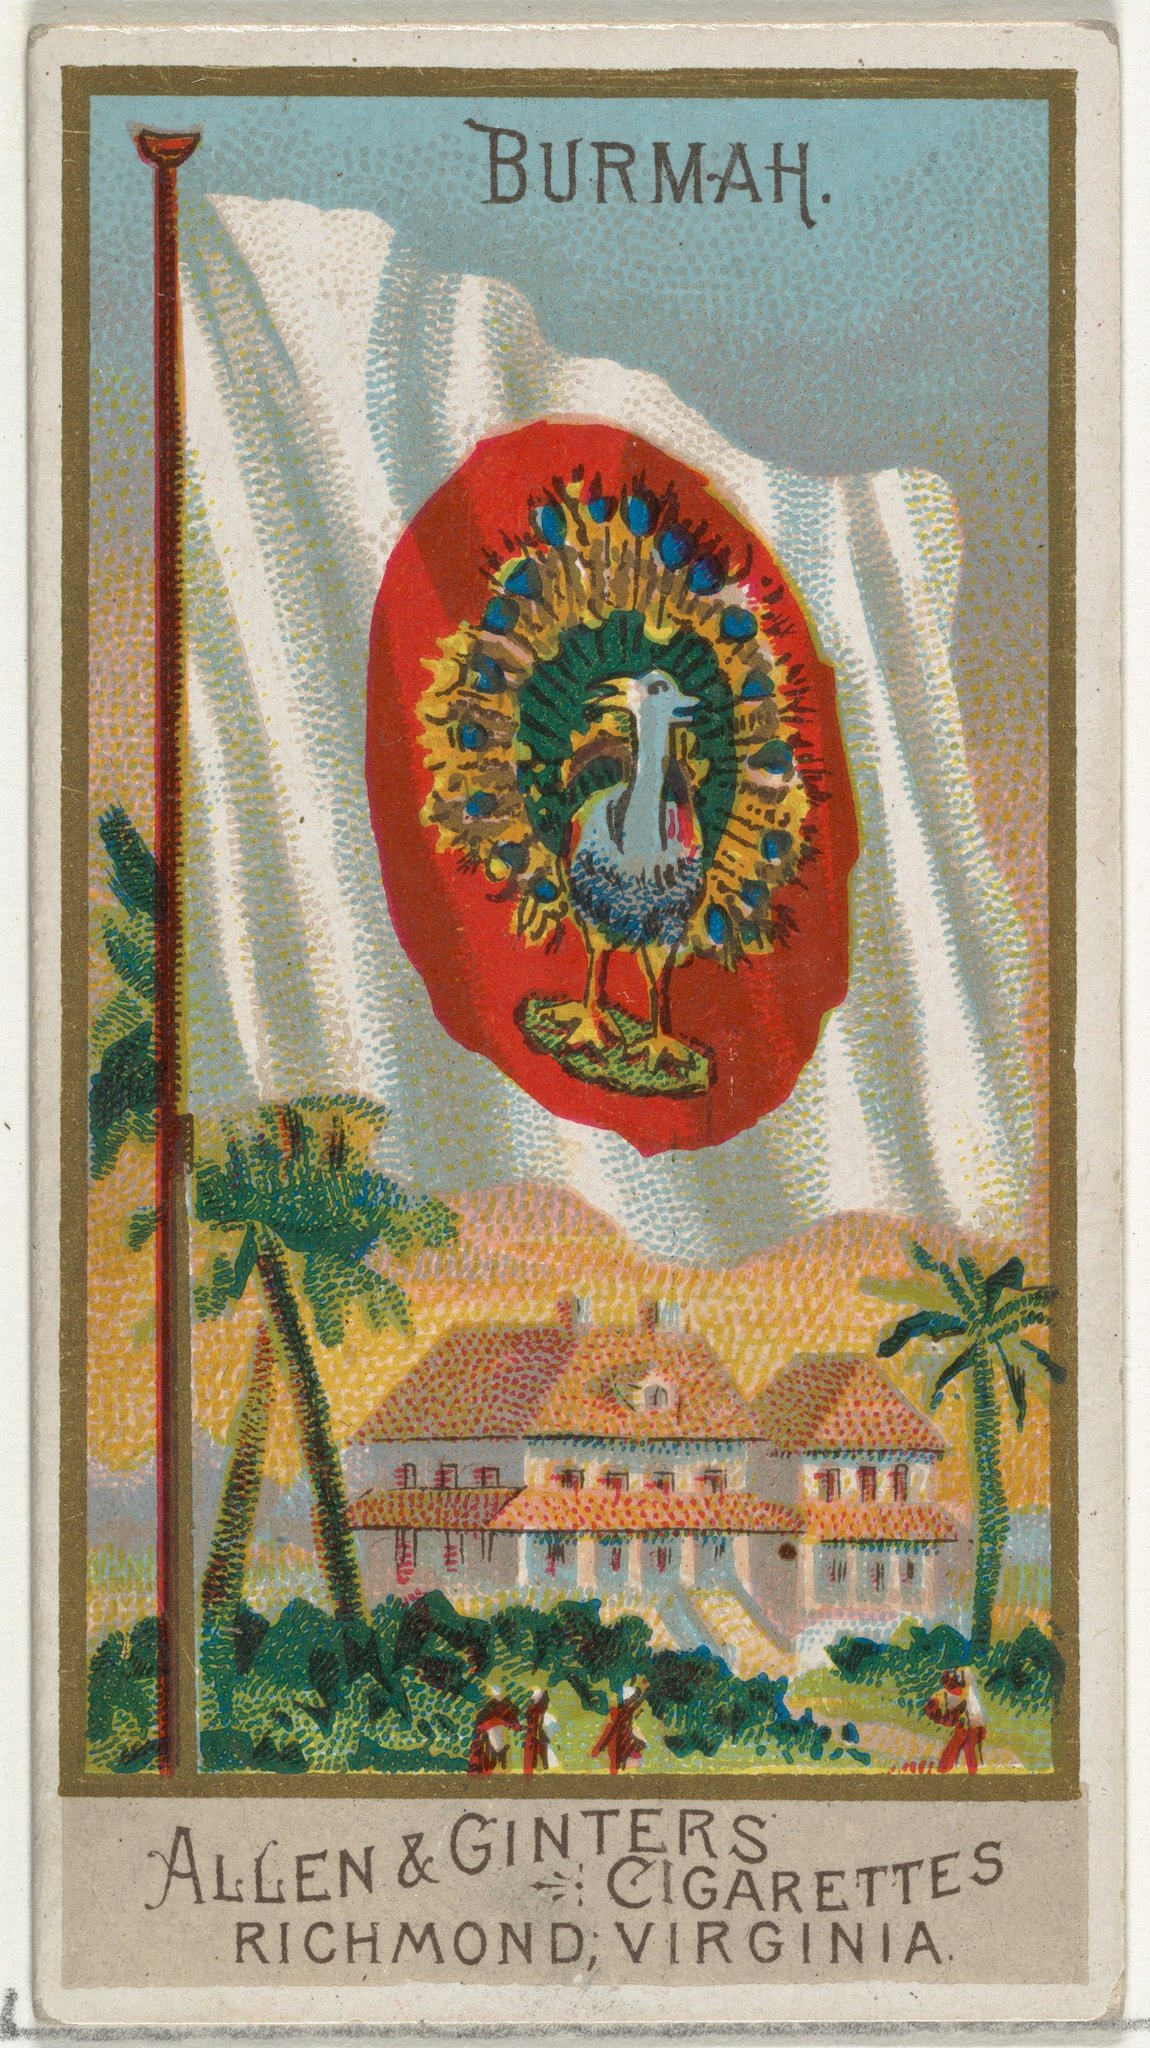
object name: print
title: Burma, from Flags of All Nations, Series 2 (N10) for Allen & Ginter Cigarettes Brands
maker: allen & ginter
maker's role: publisher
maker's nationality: american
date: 1890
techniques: color lithograph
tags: coat of arms,flags